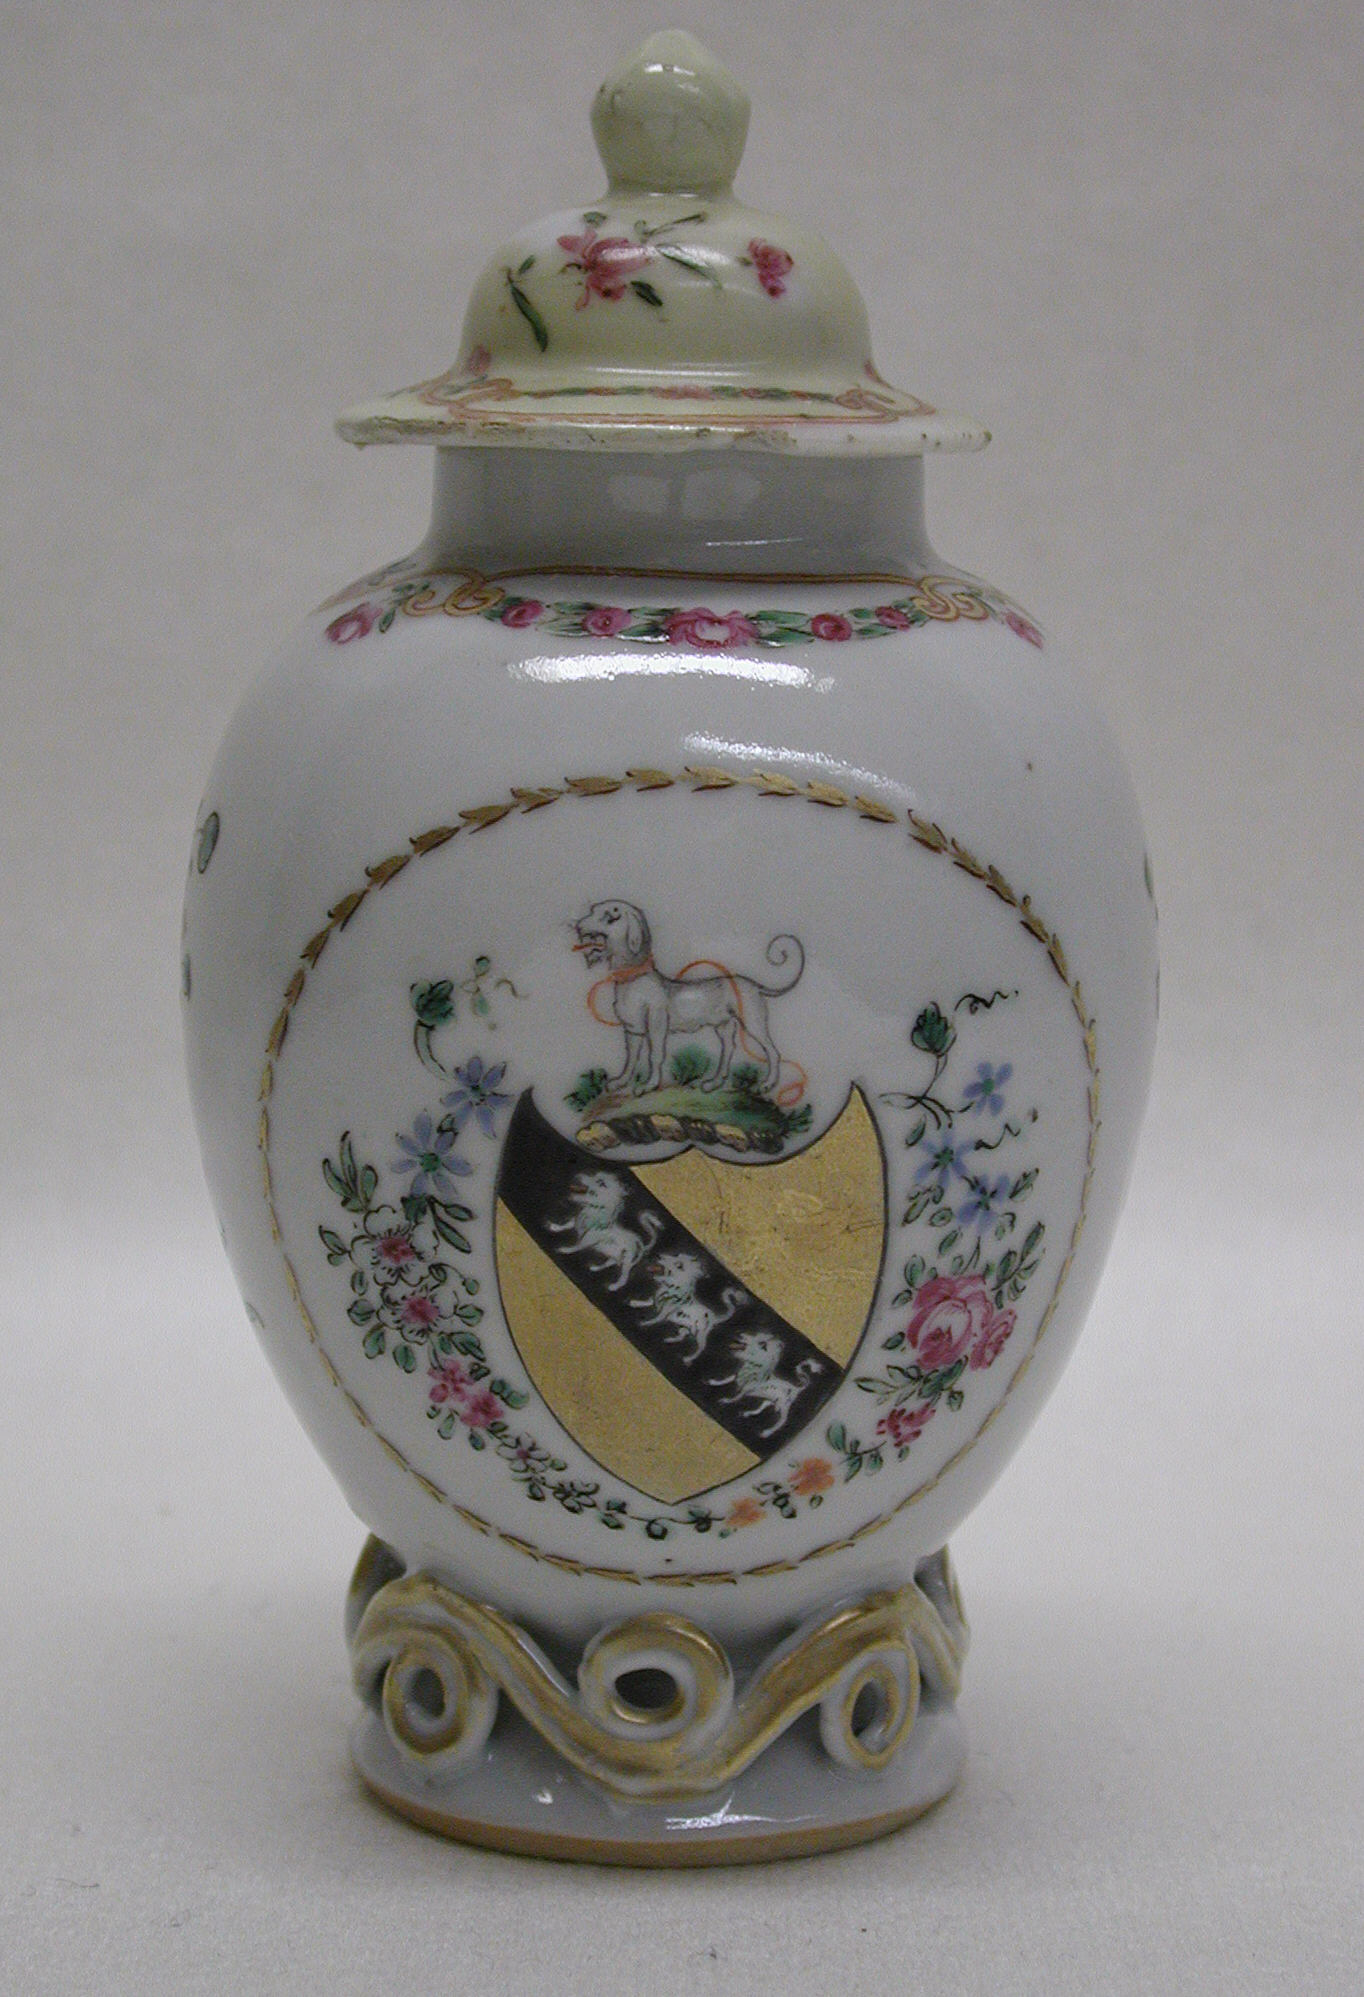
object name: tea caddy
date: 1750-1760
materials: hard paste porcelain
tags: dogs,coat of arms